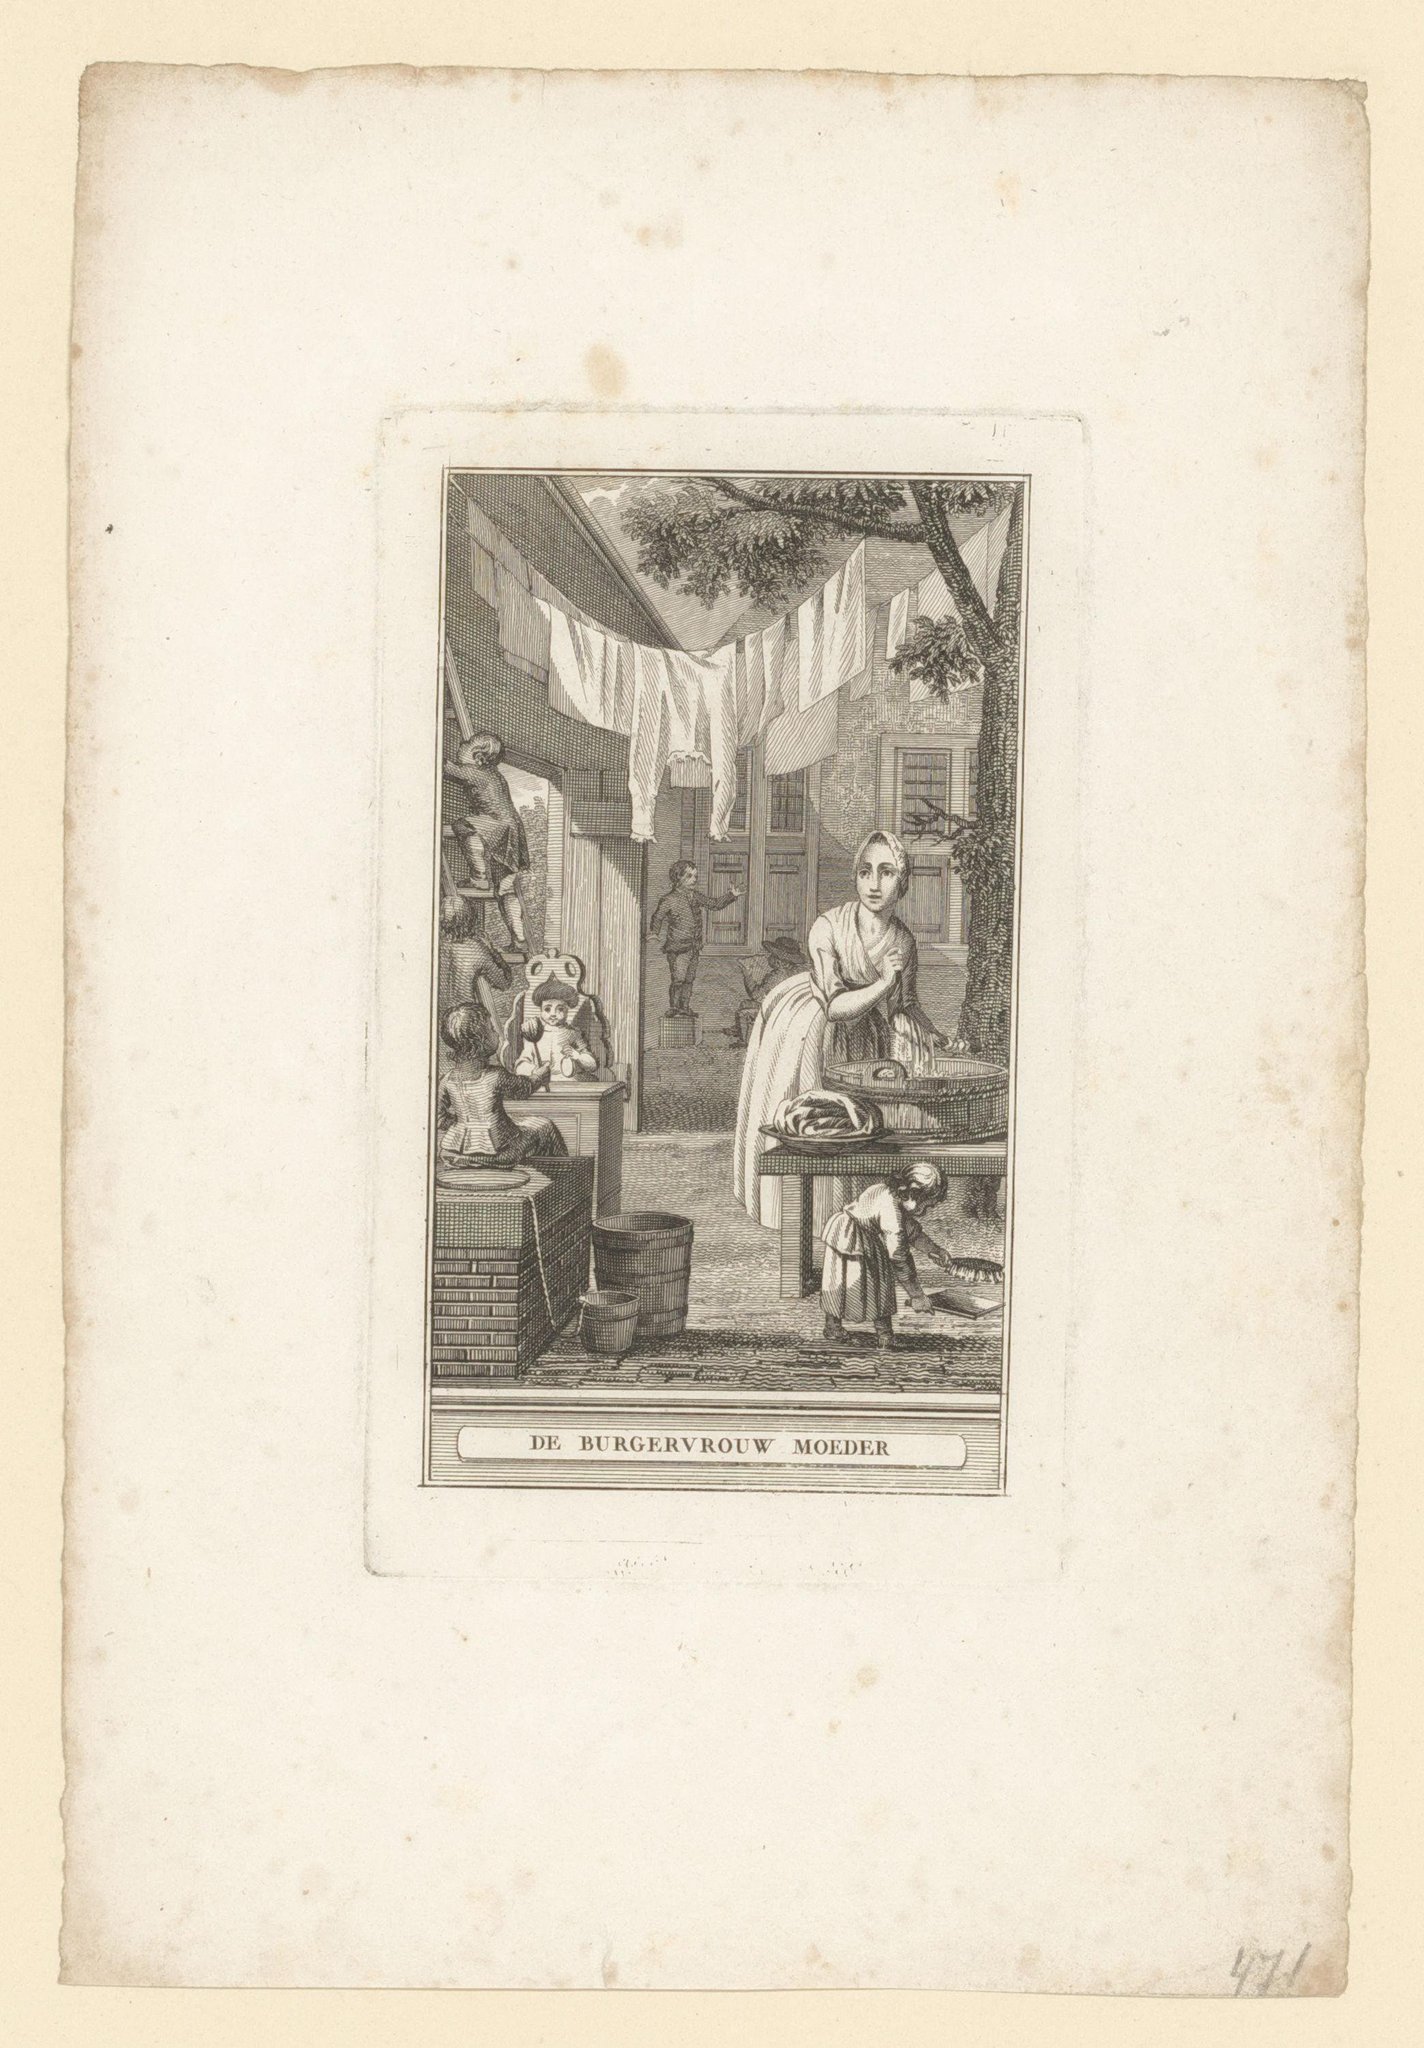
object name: book illustration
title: De burgervrouw moeder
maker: Anonymous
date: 1792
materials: paper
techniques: engraving, etching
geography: netherlands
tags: family life at home, mother-love, hanging the wash to dry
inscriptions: collector's mark: Lugt 1641, collector's mark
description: Gebruikt als illustratie in: E. Bekker en A. Deken, Economische liedjes, Den Haag: Isaac van Cleef, 1792, dl. 1. p. 45.